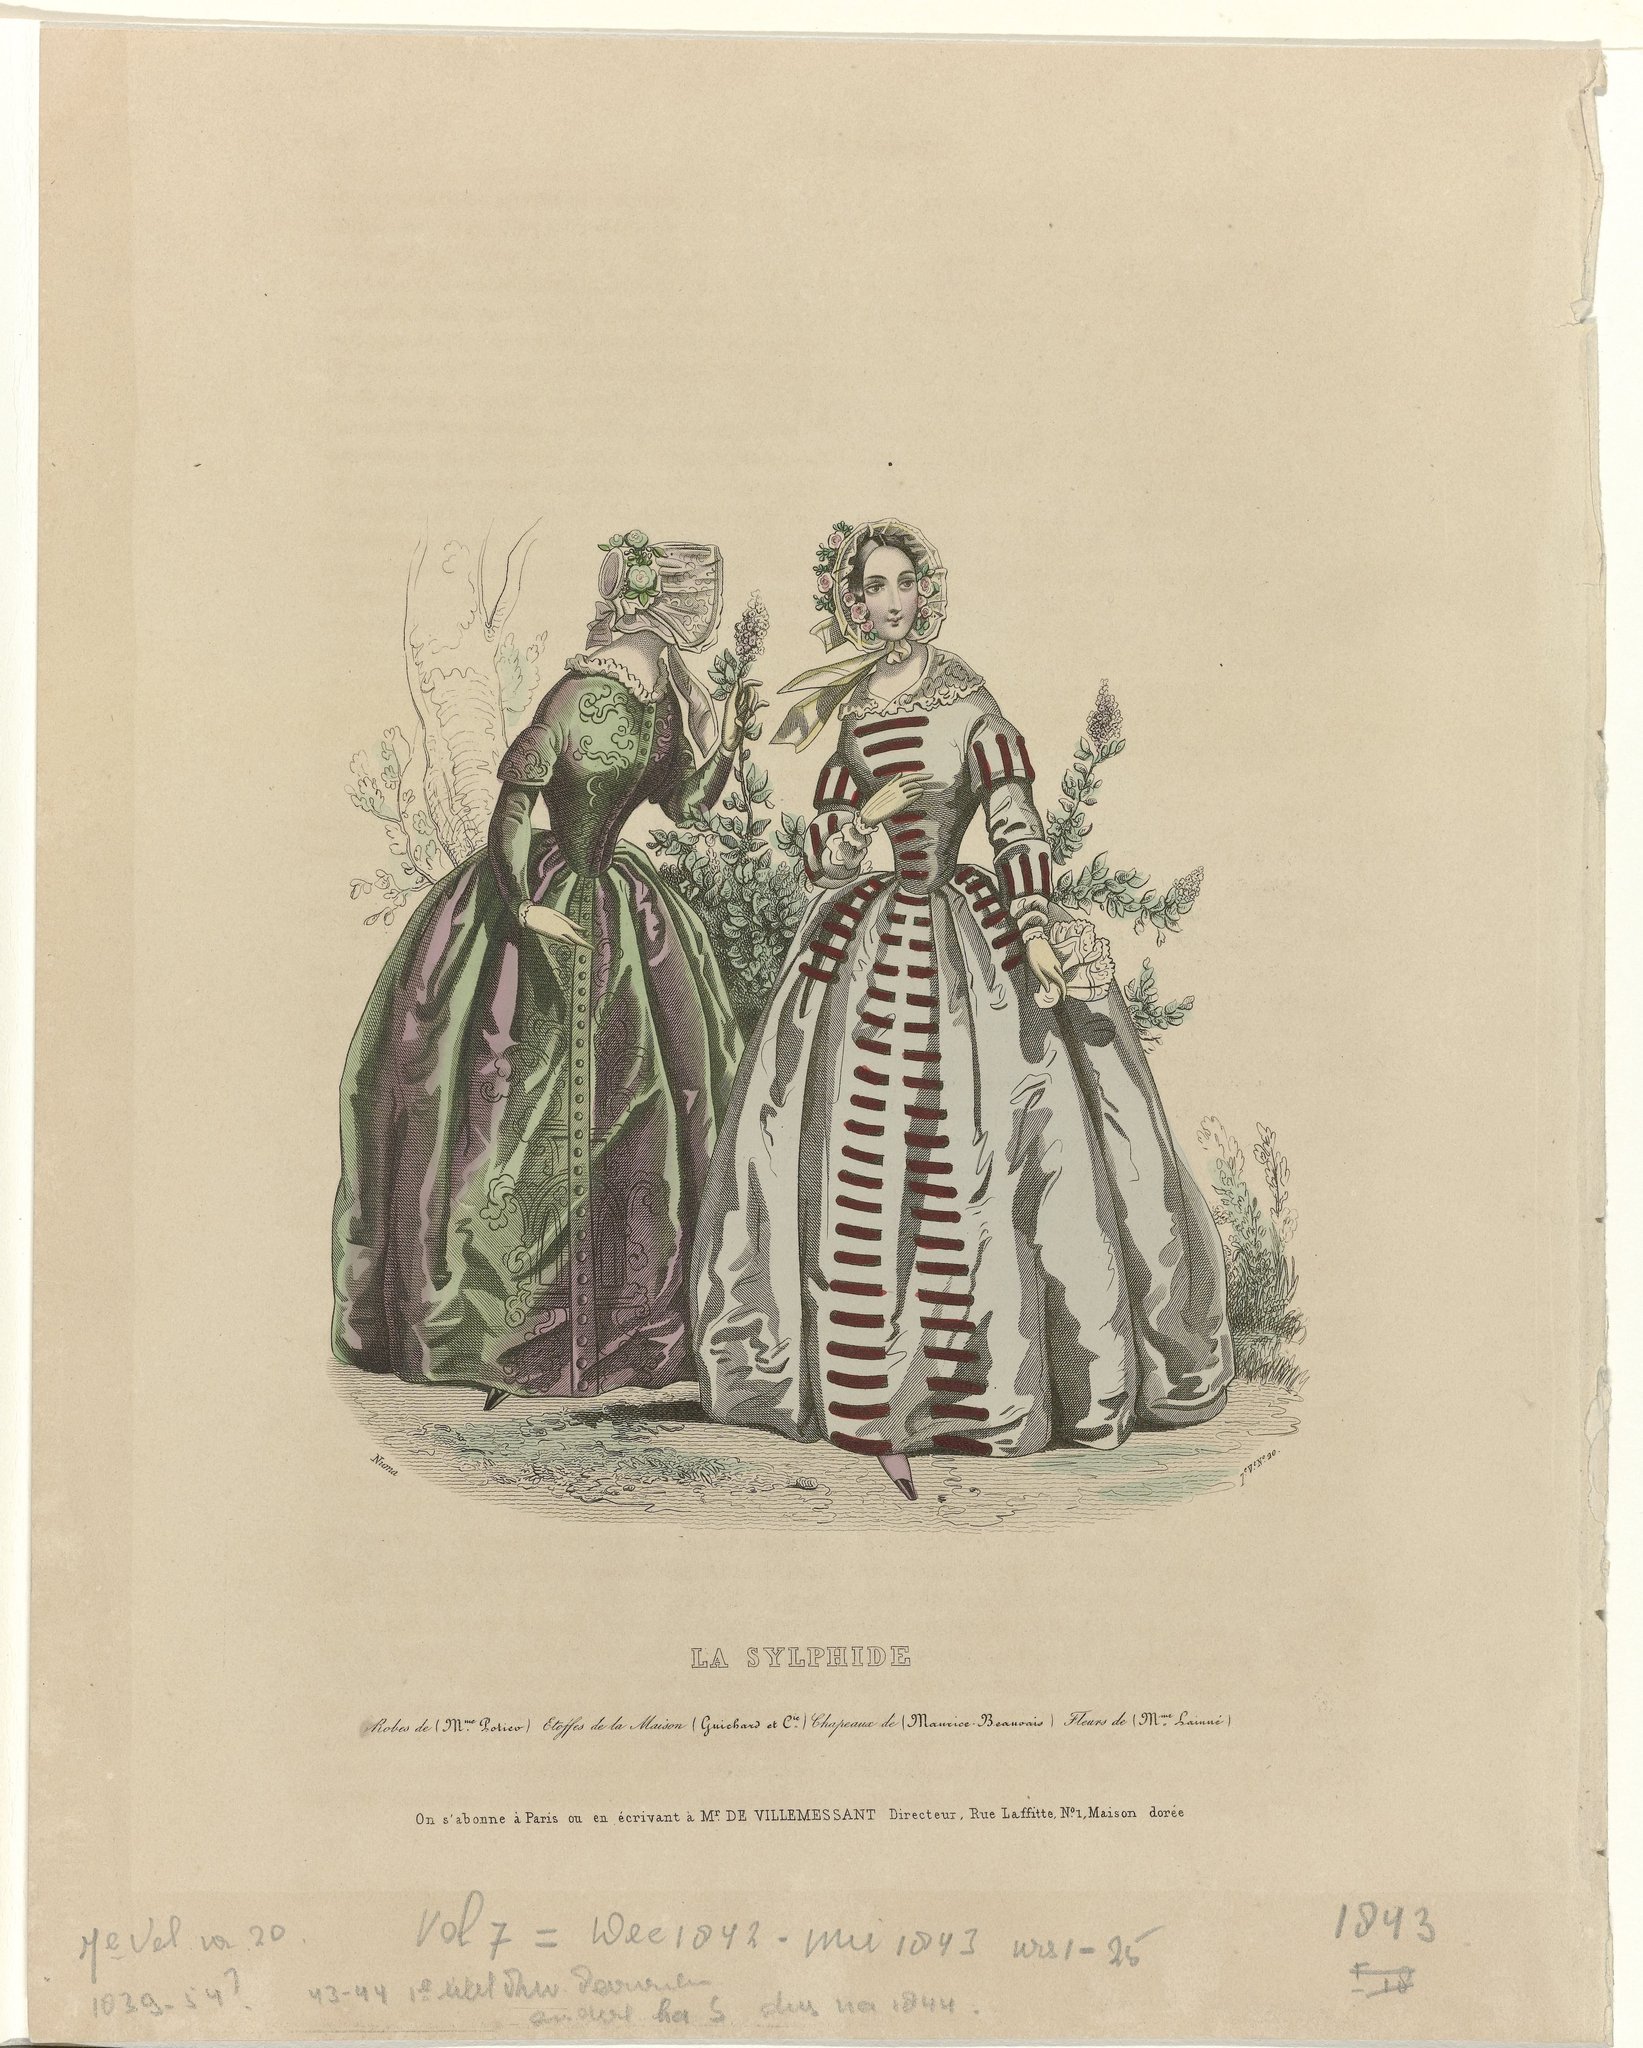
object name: fashion print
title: La Sylphide, 1843, 7e Vol., No. 20 : Robes de (Mme Potiev) (...)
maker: pierre numa bassaget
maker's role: print maker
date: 1843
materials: paper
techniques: engraving, hand coloring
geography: paris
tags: flowers, handkerchief (+ women's clothes), fashion plates, head-gear: hat (+ women's clothes), shoes, sandals (+ women's clothes), gloves, mittens, etc. (+ women's clothes), dress, gown (+ women's clothes), neck-gear ~ clothing (+ women's clothes)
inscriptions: caption: ‘Robes de (M"me Potiev) Etoffes de la Maison (Guichard et C"ie) Chapeaux de (Maurice-Beauvais) Fleurs de (M"me Lainné)’, title: ‘La Sylphide’, address: ‘On 's abonne à Paris, ou en écrivant à M.r de Villemessant Directeur, Rue Laffitte, No.1, Maison dorée.’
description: Twee vrouwen in een tuin. Volgens het onderschrift: japonnen van Potiev. Stoffen van de firma Guichard et Cie. Hoeden van Maurice-Beauvais. Bloemen van Lainné. Prent uit het modetijdschrift La Sylphide (1839-1885).